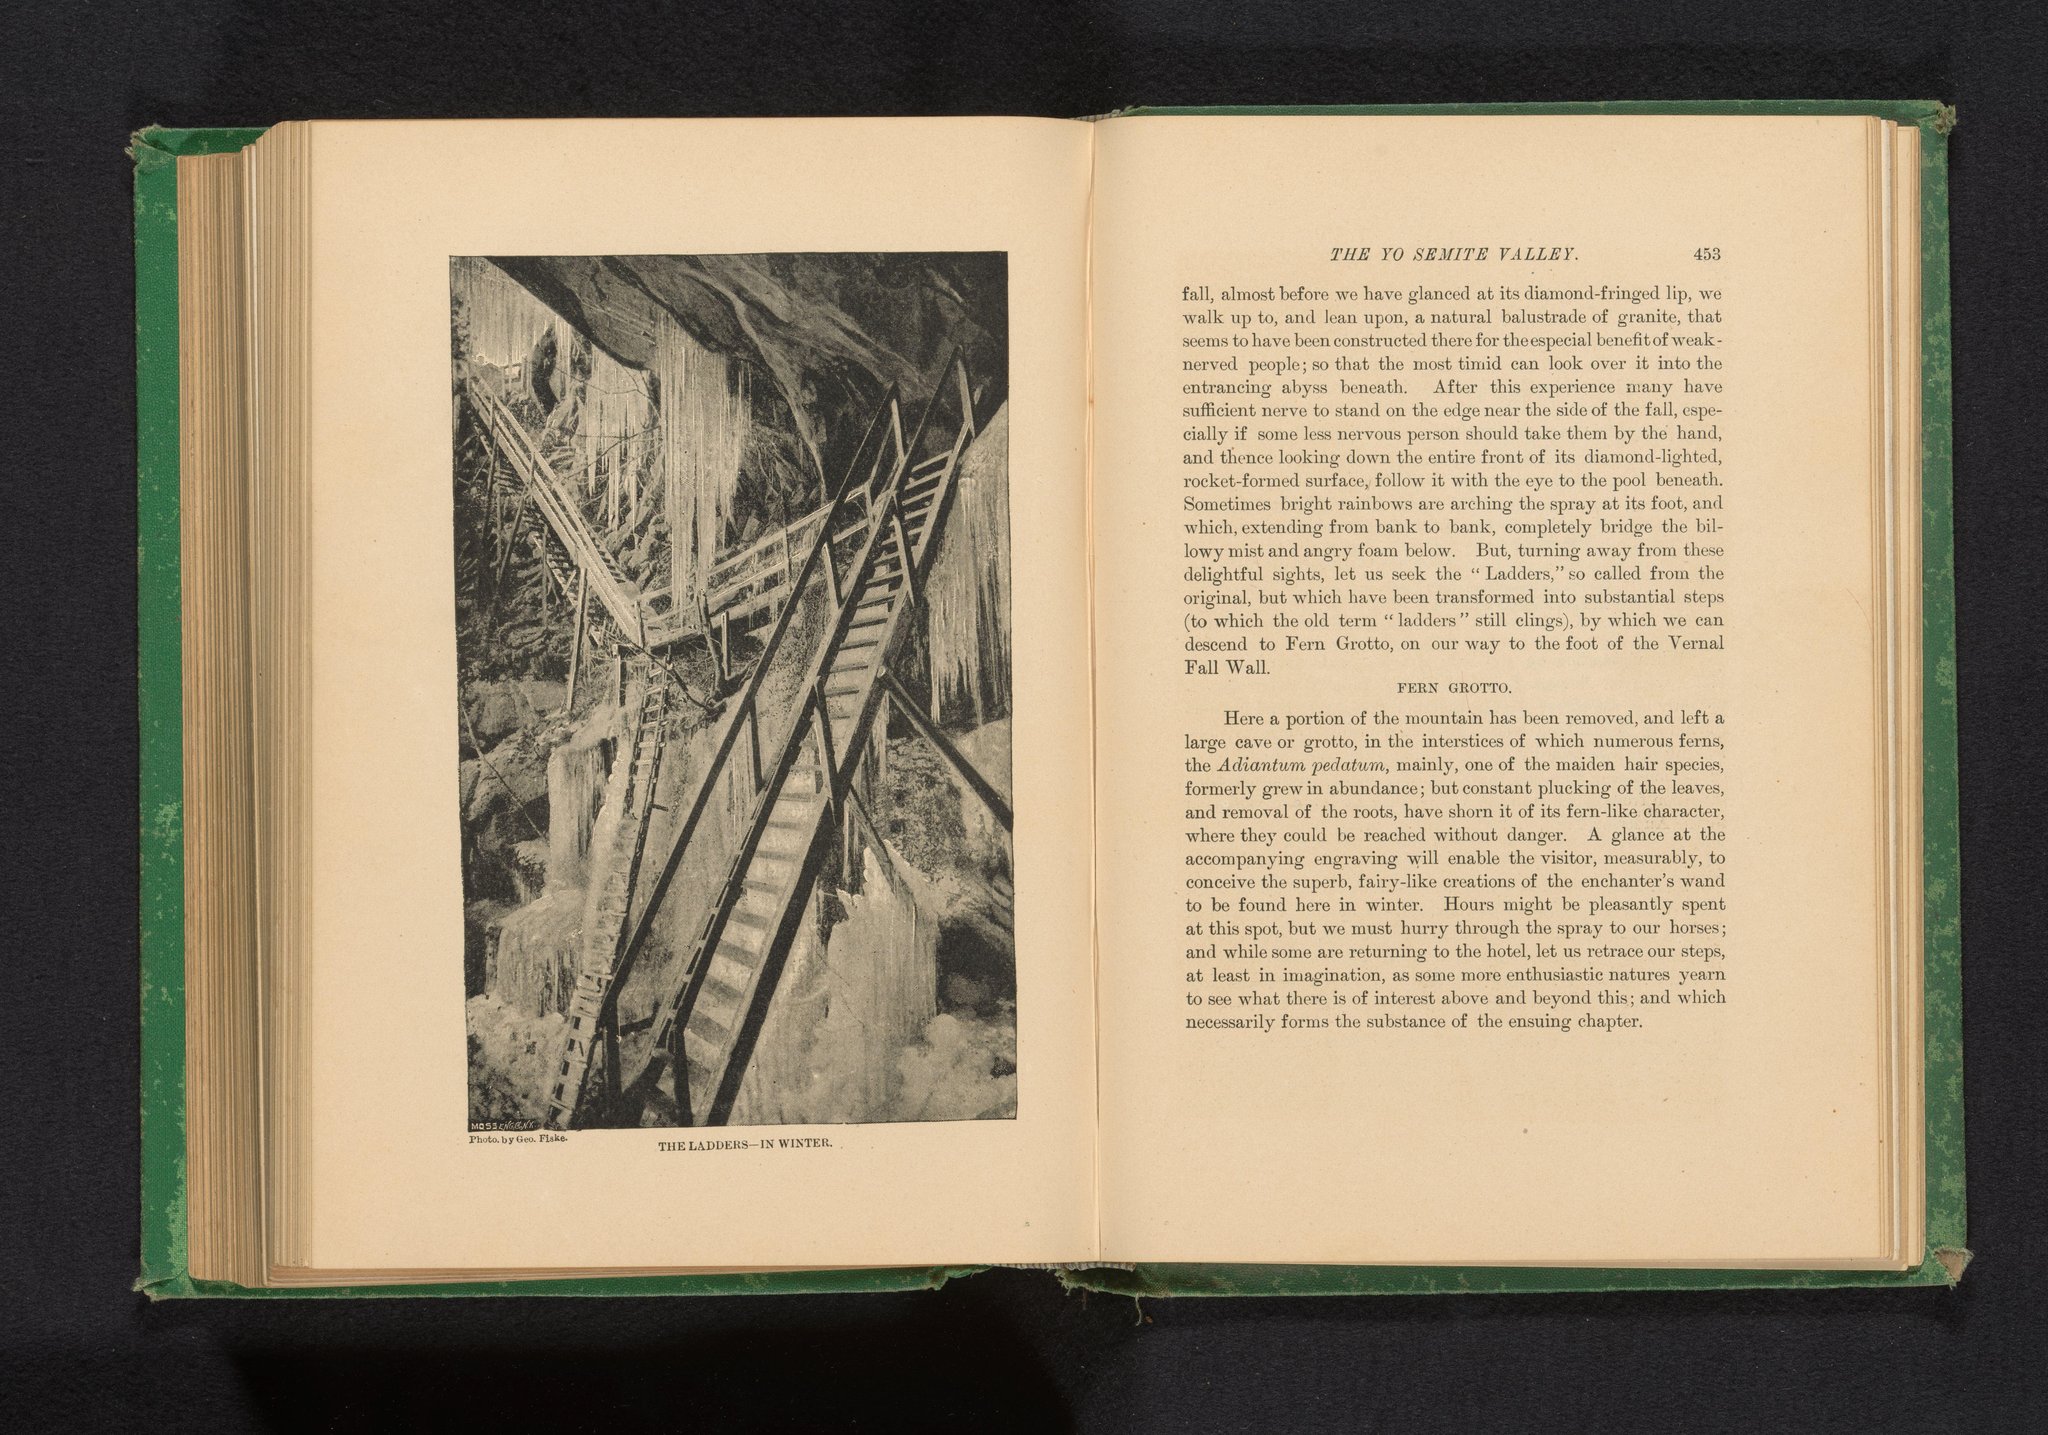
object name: photomechanical print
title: Ladders tegen een bergwand met ijspegels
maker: george fiske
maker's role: fotograaf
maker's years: 1835-1918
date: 1881-1886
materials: paper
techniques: printing block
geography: new york city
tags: ice ~ freezing weather, ladder